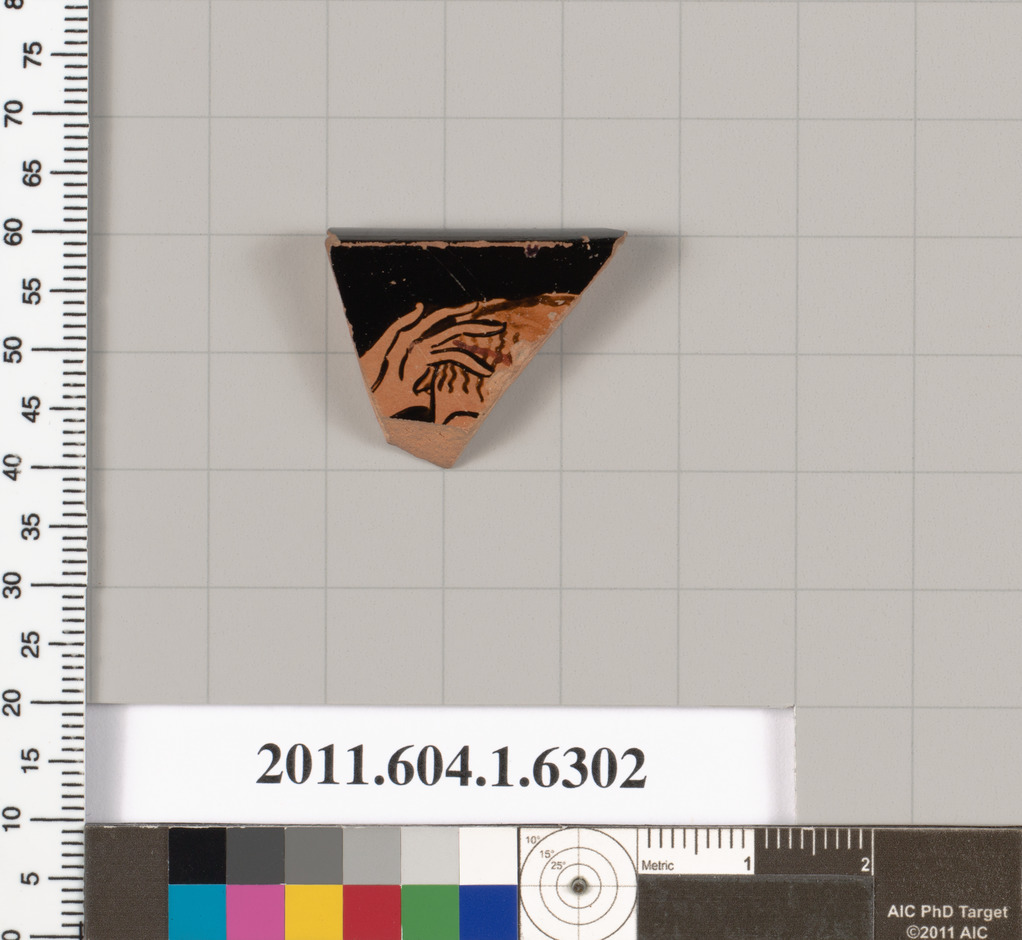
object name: kylix fragment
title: Terracotta rim fragment of a kylix (drinking cup)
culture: greek, attic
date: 500-480 BCE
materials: terracotta